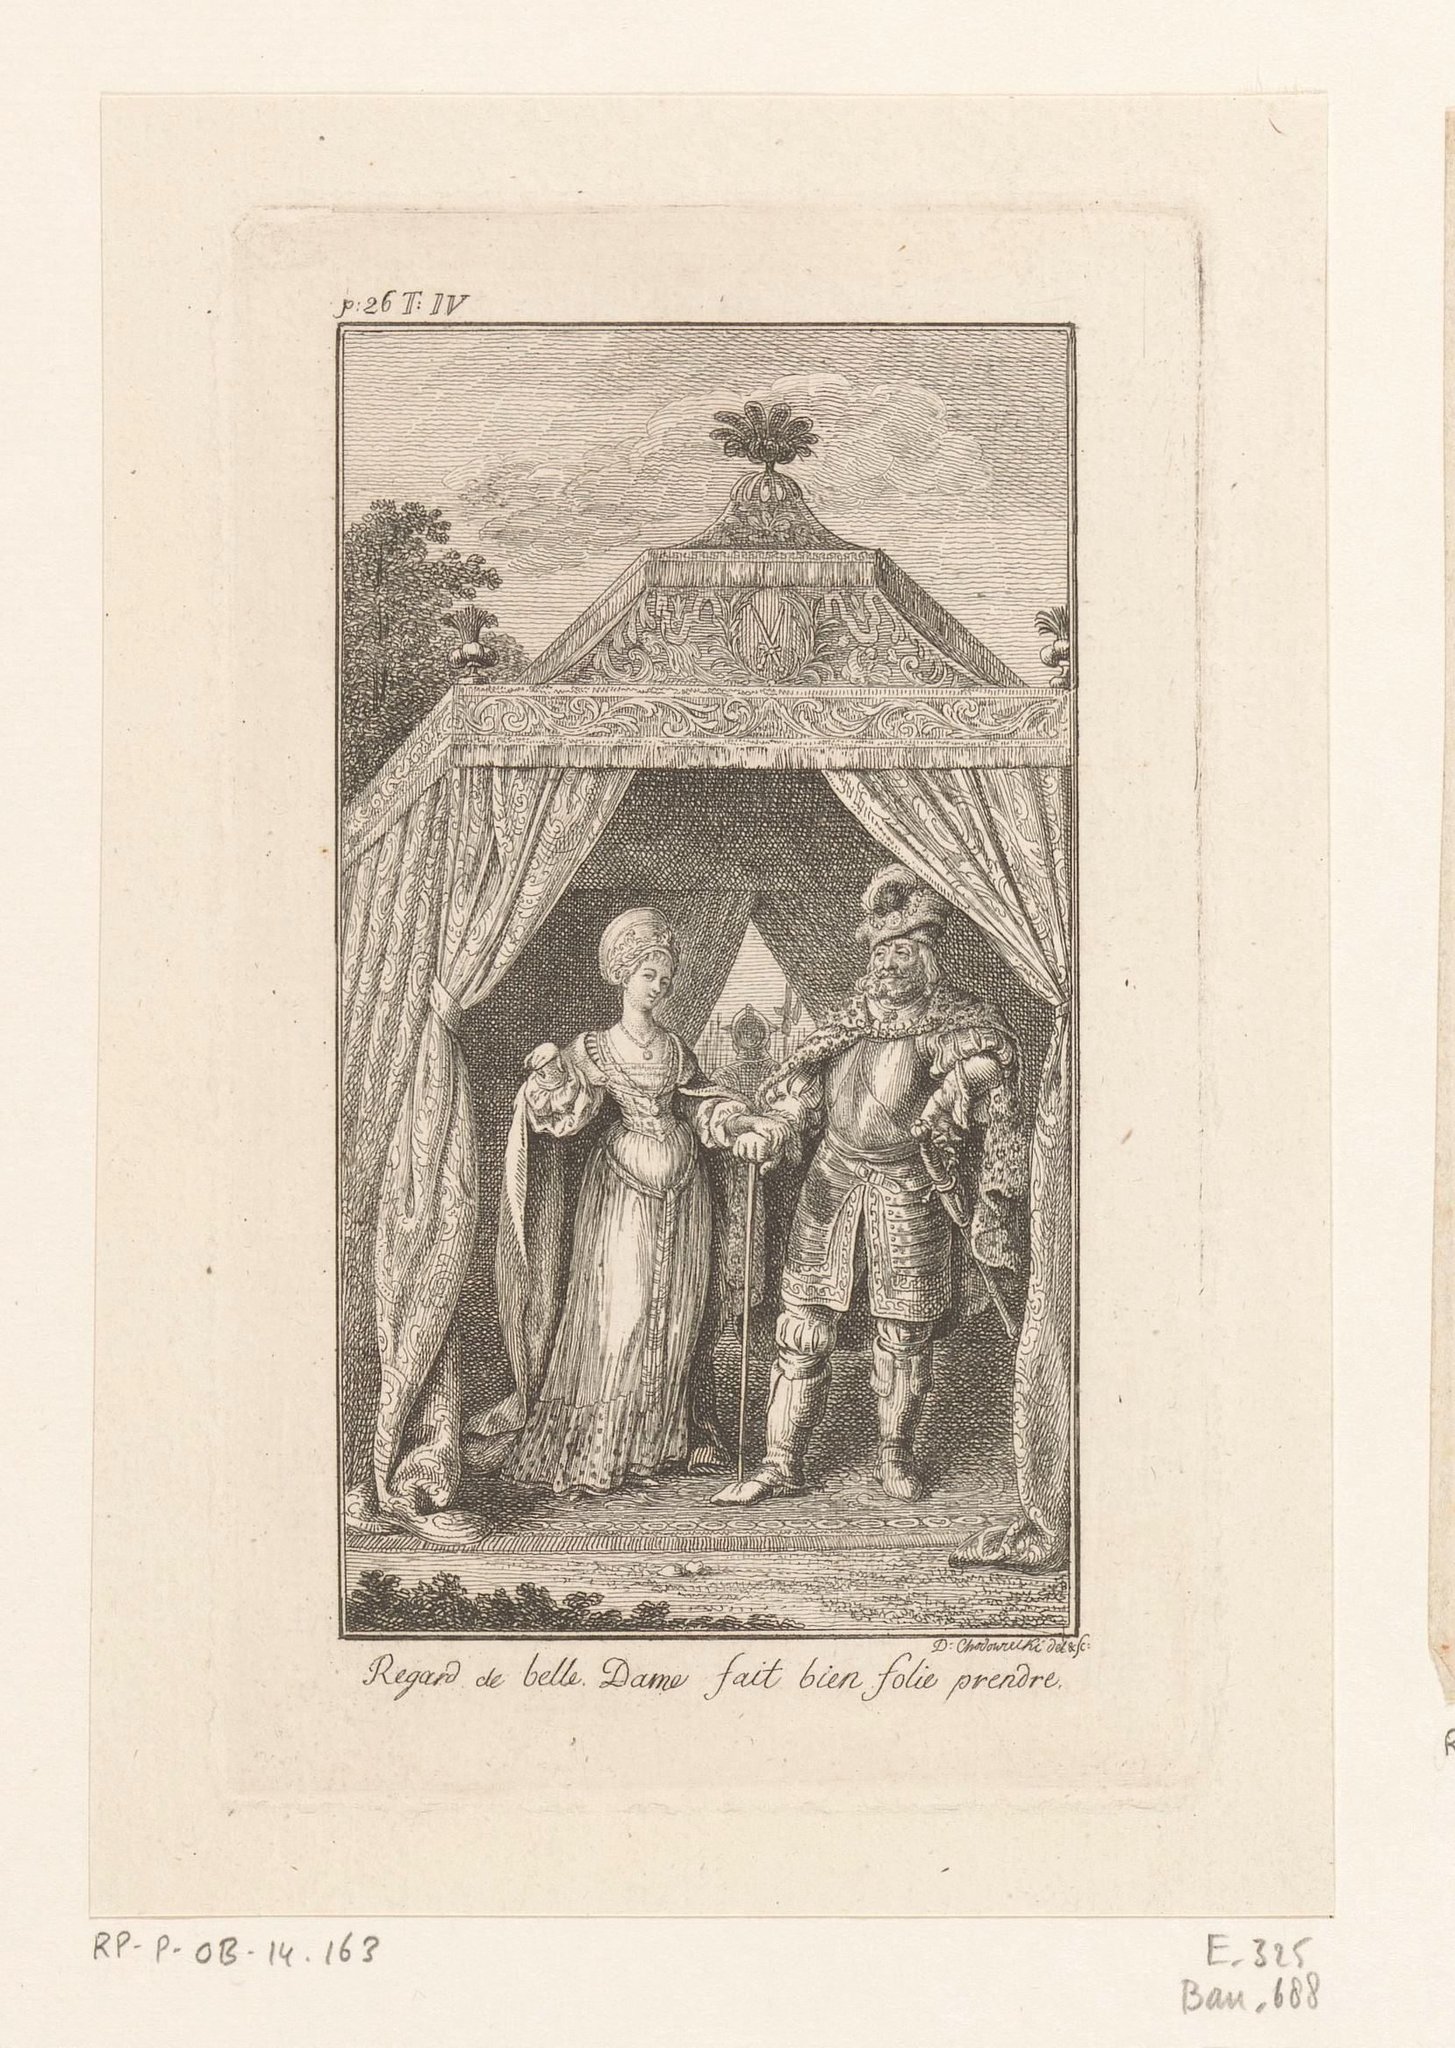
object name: print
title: Sibille en Widukund in een tent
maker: daniel nikolaus chodowiecki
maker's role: draughtsman, print maker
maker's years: 1726-1801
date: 1779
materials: paper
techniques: etching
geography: berlin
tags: (military) camp with tents, literature, armour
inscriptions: collector's mark: Lugt 2228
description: De rivaliserende legers van Widukind en Karel de Grote worden gescheiden door een rivier. Sibille, de vrouw van Widukind, weet dat zich in het Frankische legerkamp geen vrouwen bevinden en stelt haar man voor om de vijand door middel van haar schoonheid in de val te lokken: 'Regard de belle Dame fait bien folie prendre'. Linksboven genummerd: p.26 T: IV.